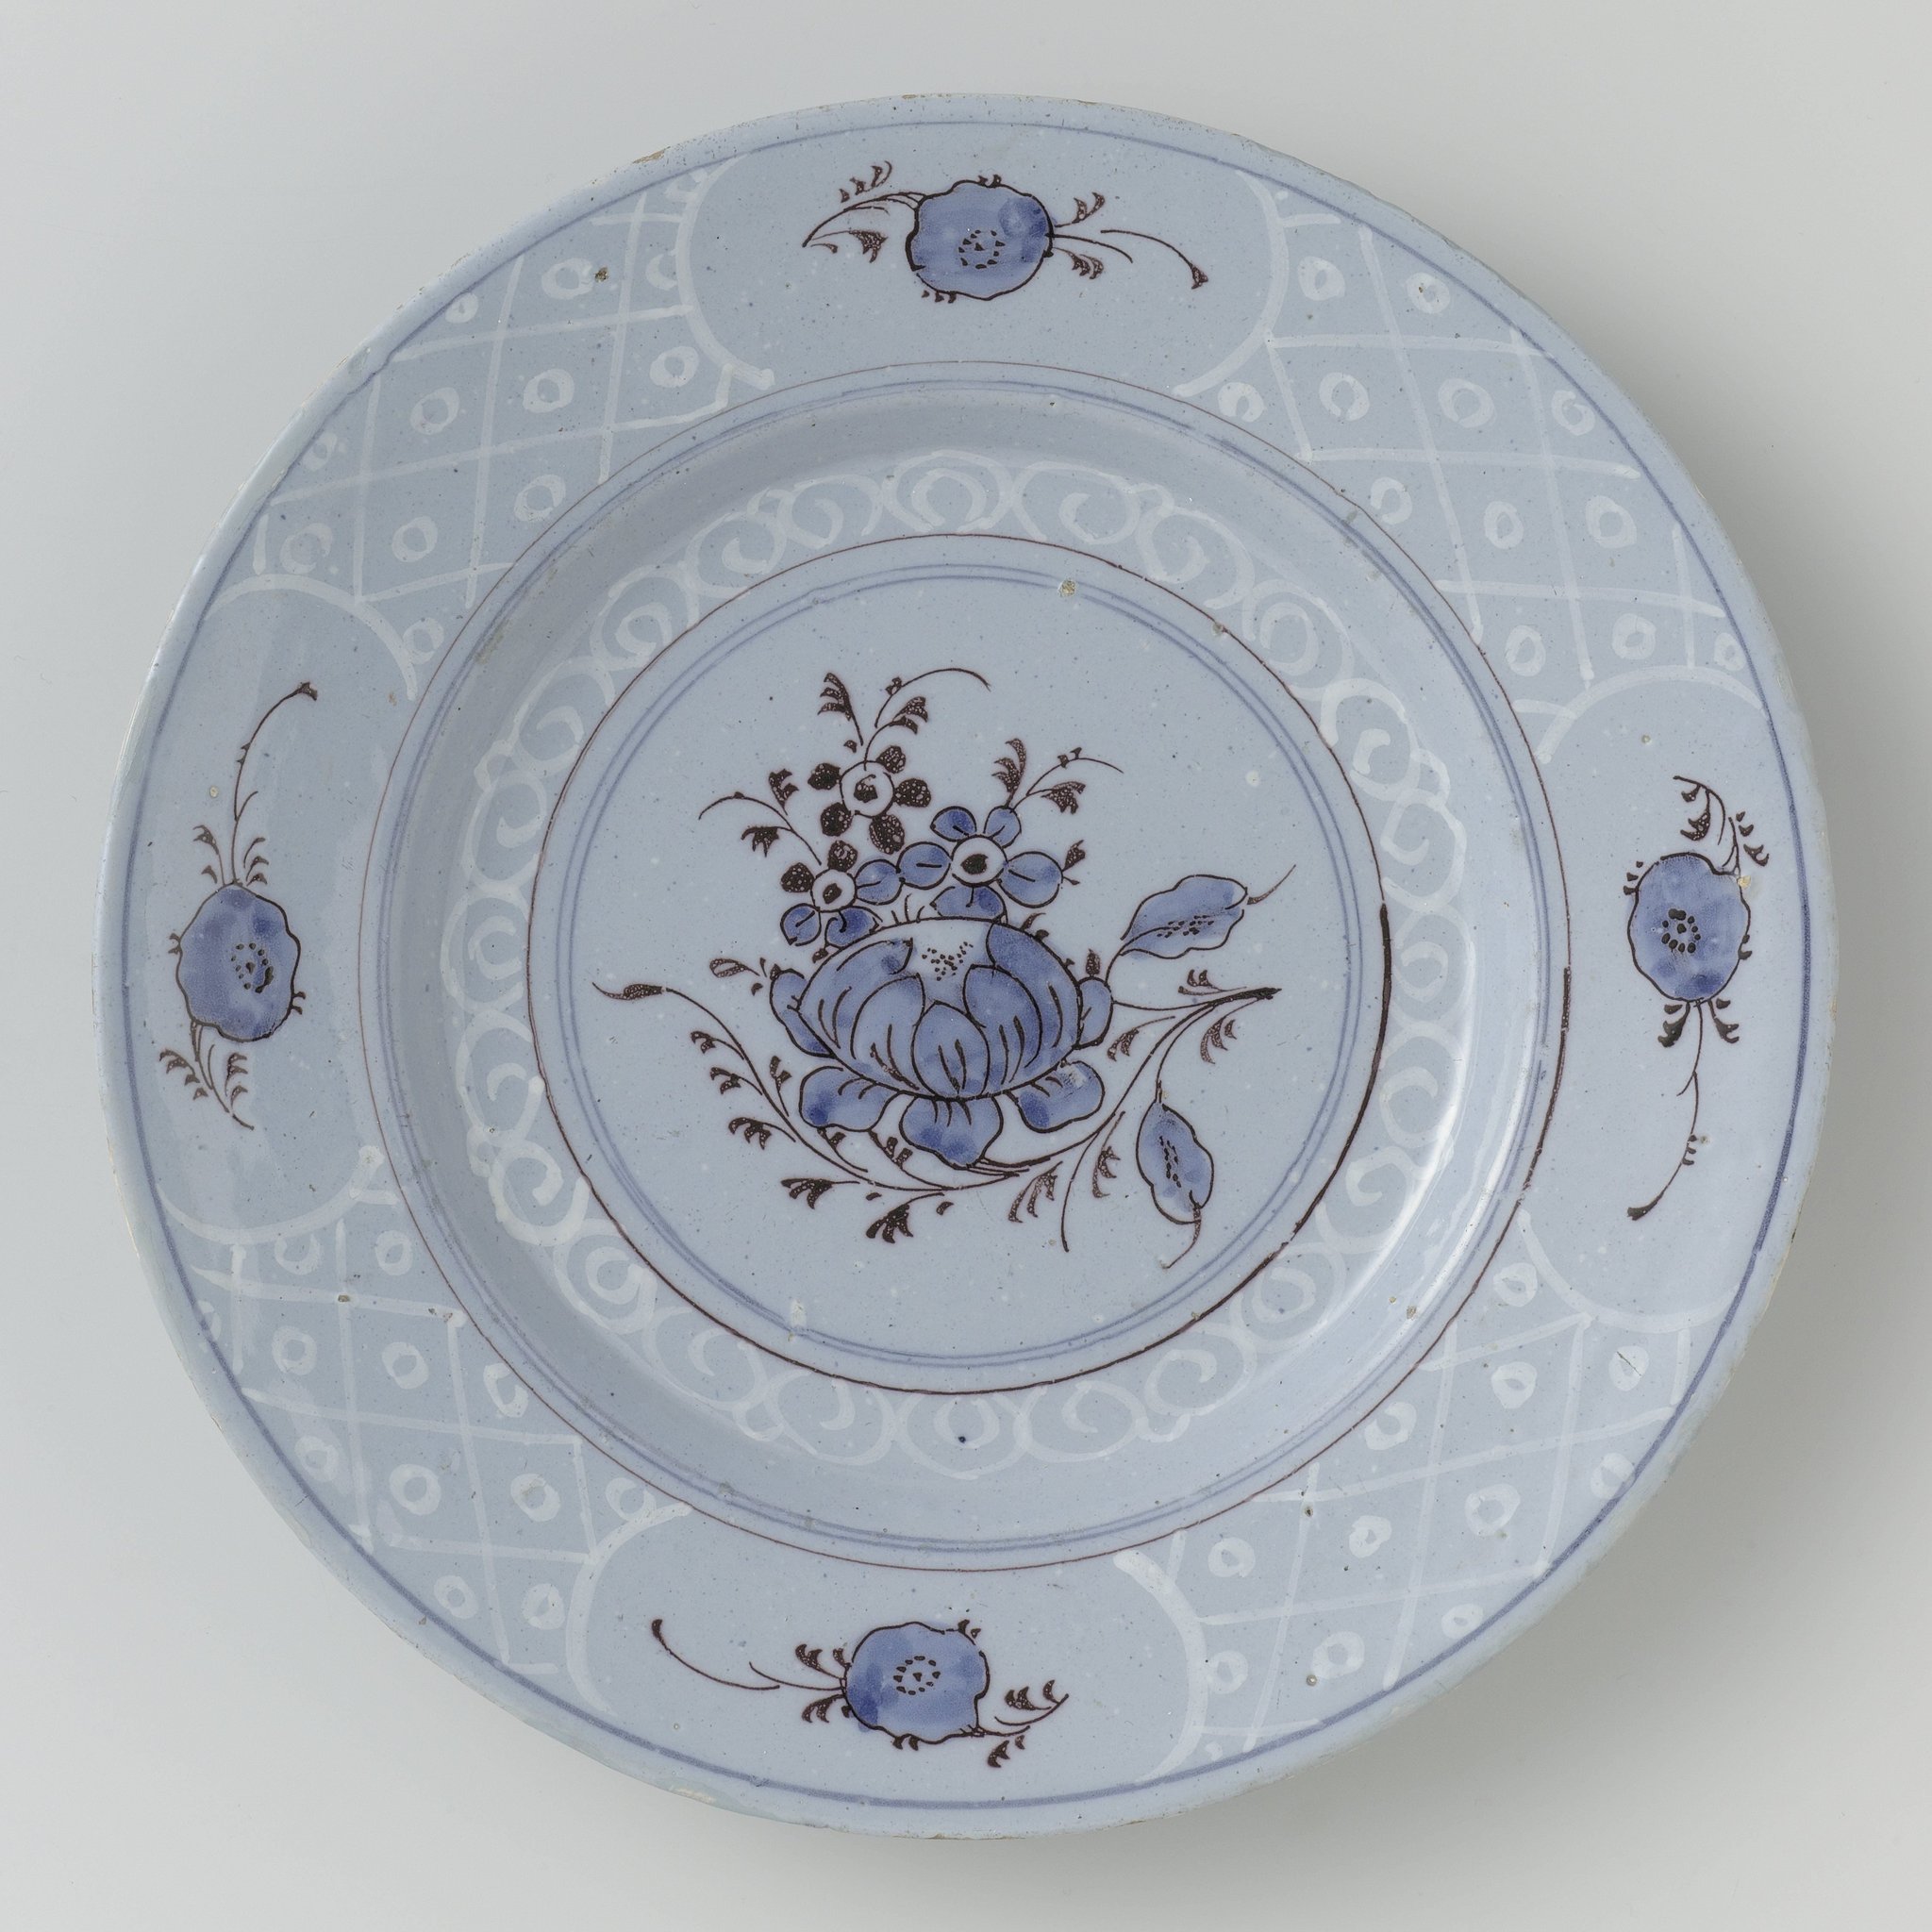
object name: plate dish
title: Bord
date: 1760-1780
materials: earthenware, glaze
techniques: painted, polychromy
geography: delft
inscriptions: mark: ‘' t fortuijn’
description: Rond bord van veelkleurig beschilderde faience. Op een licht-blauwe fond is op het plat een bloem in de kleuren paars en blauw geschilderd. De rand heeft een wit geruite ondergrond met daarin vier ovale vakken. In de vakken zijn bloemen in de kleuren paars en blauw geschilderd. Het bord is gemerkt.